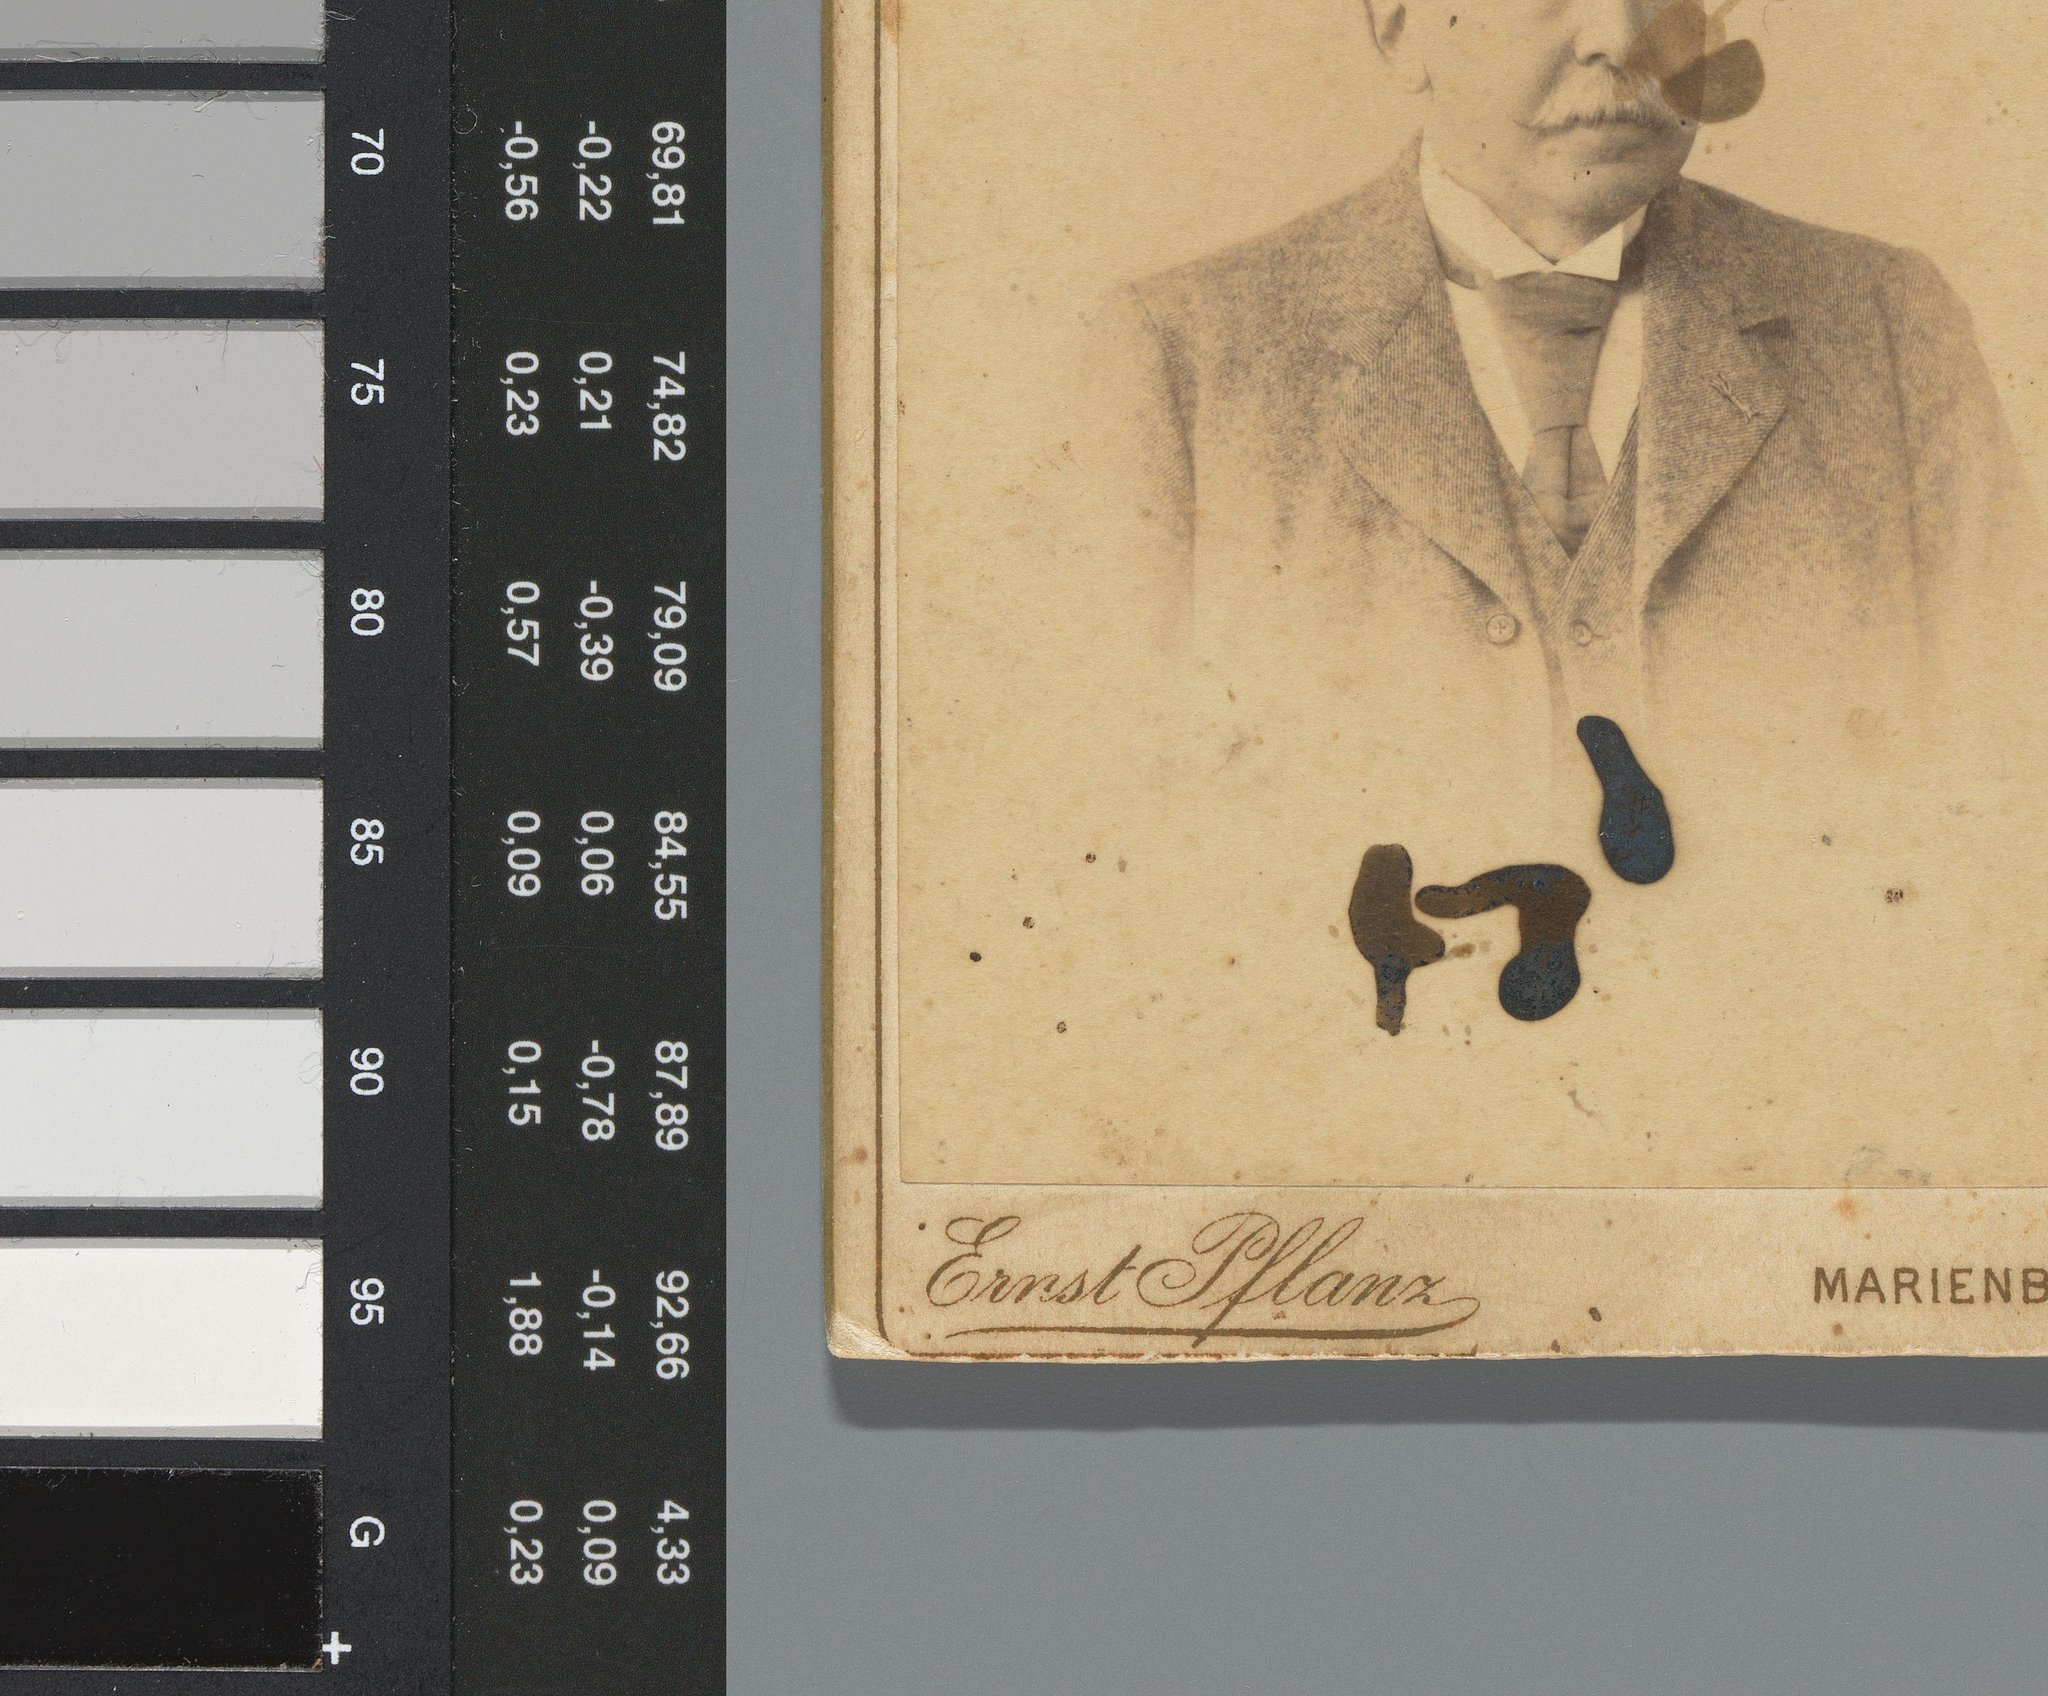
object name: photograph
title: Portret van Norbert van den Berg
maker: ernst pflanz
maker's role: painter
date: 1865-1885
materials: cardboard, photographic support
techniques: albumen print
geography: marienbad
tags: rotterdam, amsterdam, norbertus petrus van den berg (1831-1917)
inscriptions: name: ‘VIRIBUS UNITIS / ERNST PFLANZ MALER ? & PHOTOGRAPH / MARIENBAD / WALDQUELL ALLEE / VILLA PFLANZ’